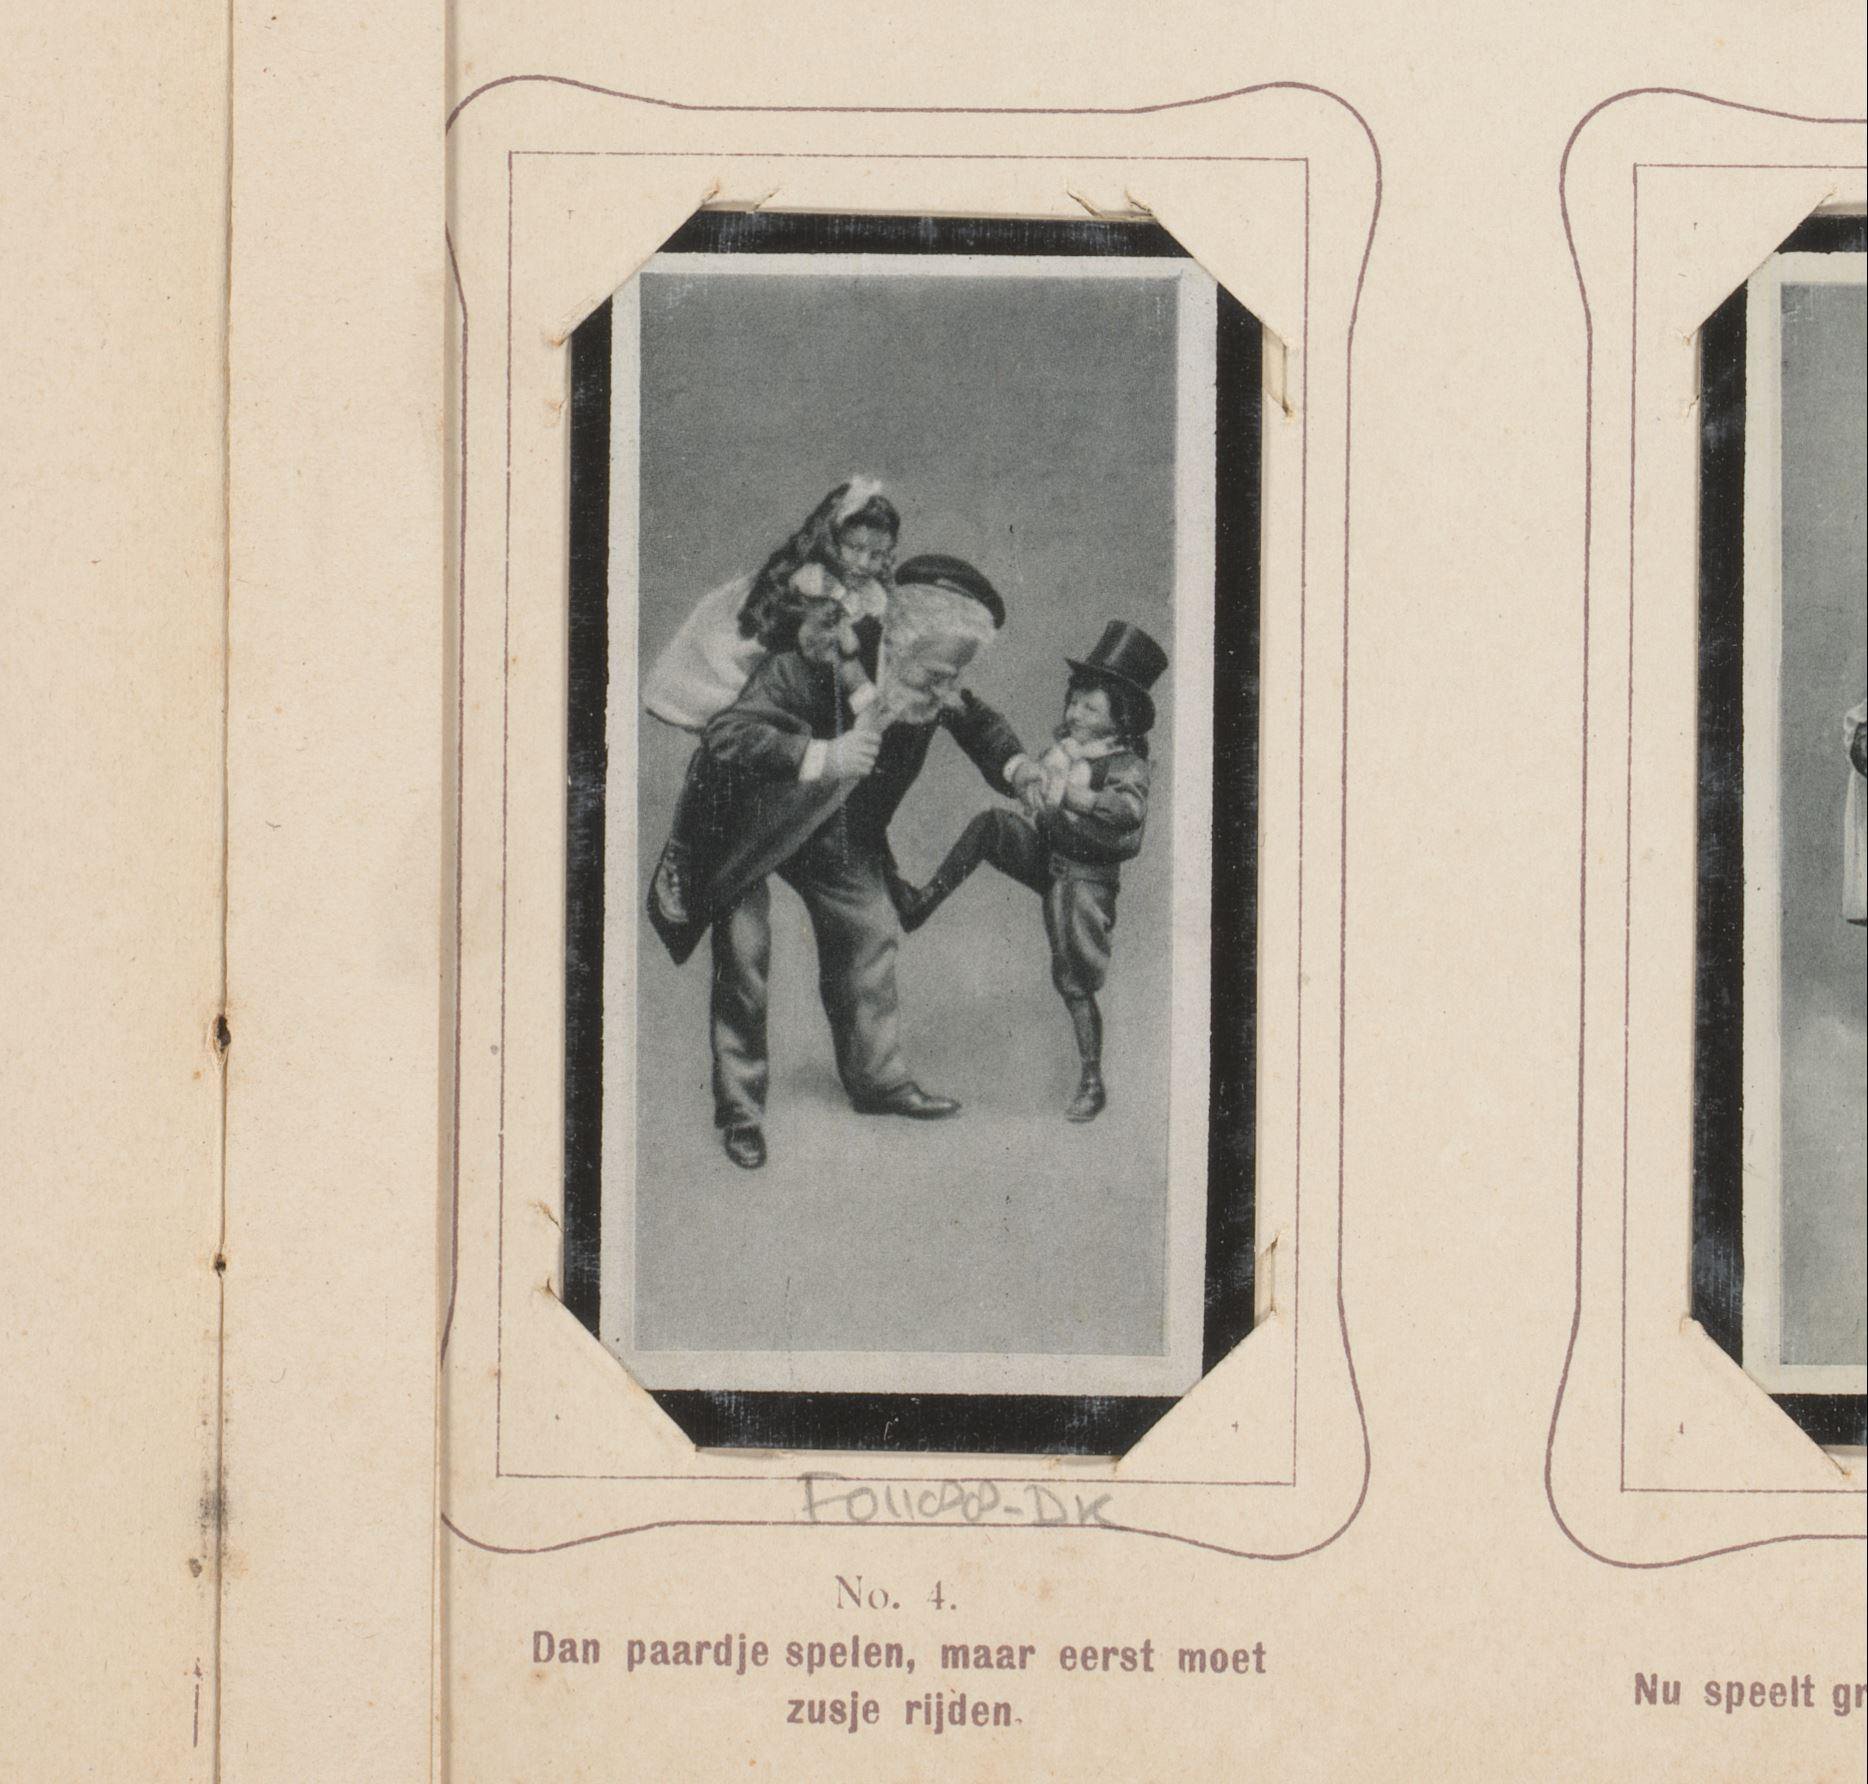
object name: album leaf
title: Reproductie van een tekening van een opa spelend met zijn kleinkinderen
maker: Anonymous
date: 1906-1907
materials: paper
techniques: photograph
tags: children's games and plays, grandparent(s) with grandchild(ren) (family group)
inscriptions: inscription: ‘No. 4./ Dan paardje spelen, maar eerst moet zusje rijden.’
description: Deze prent maakt deel uit van een album.